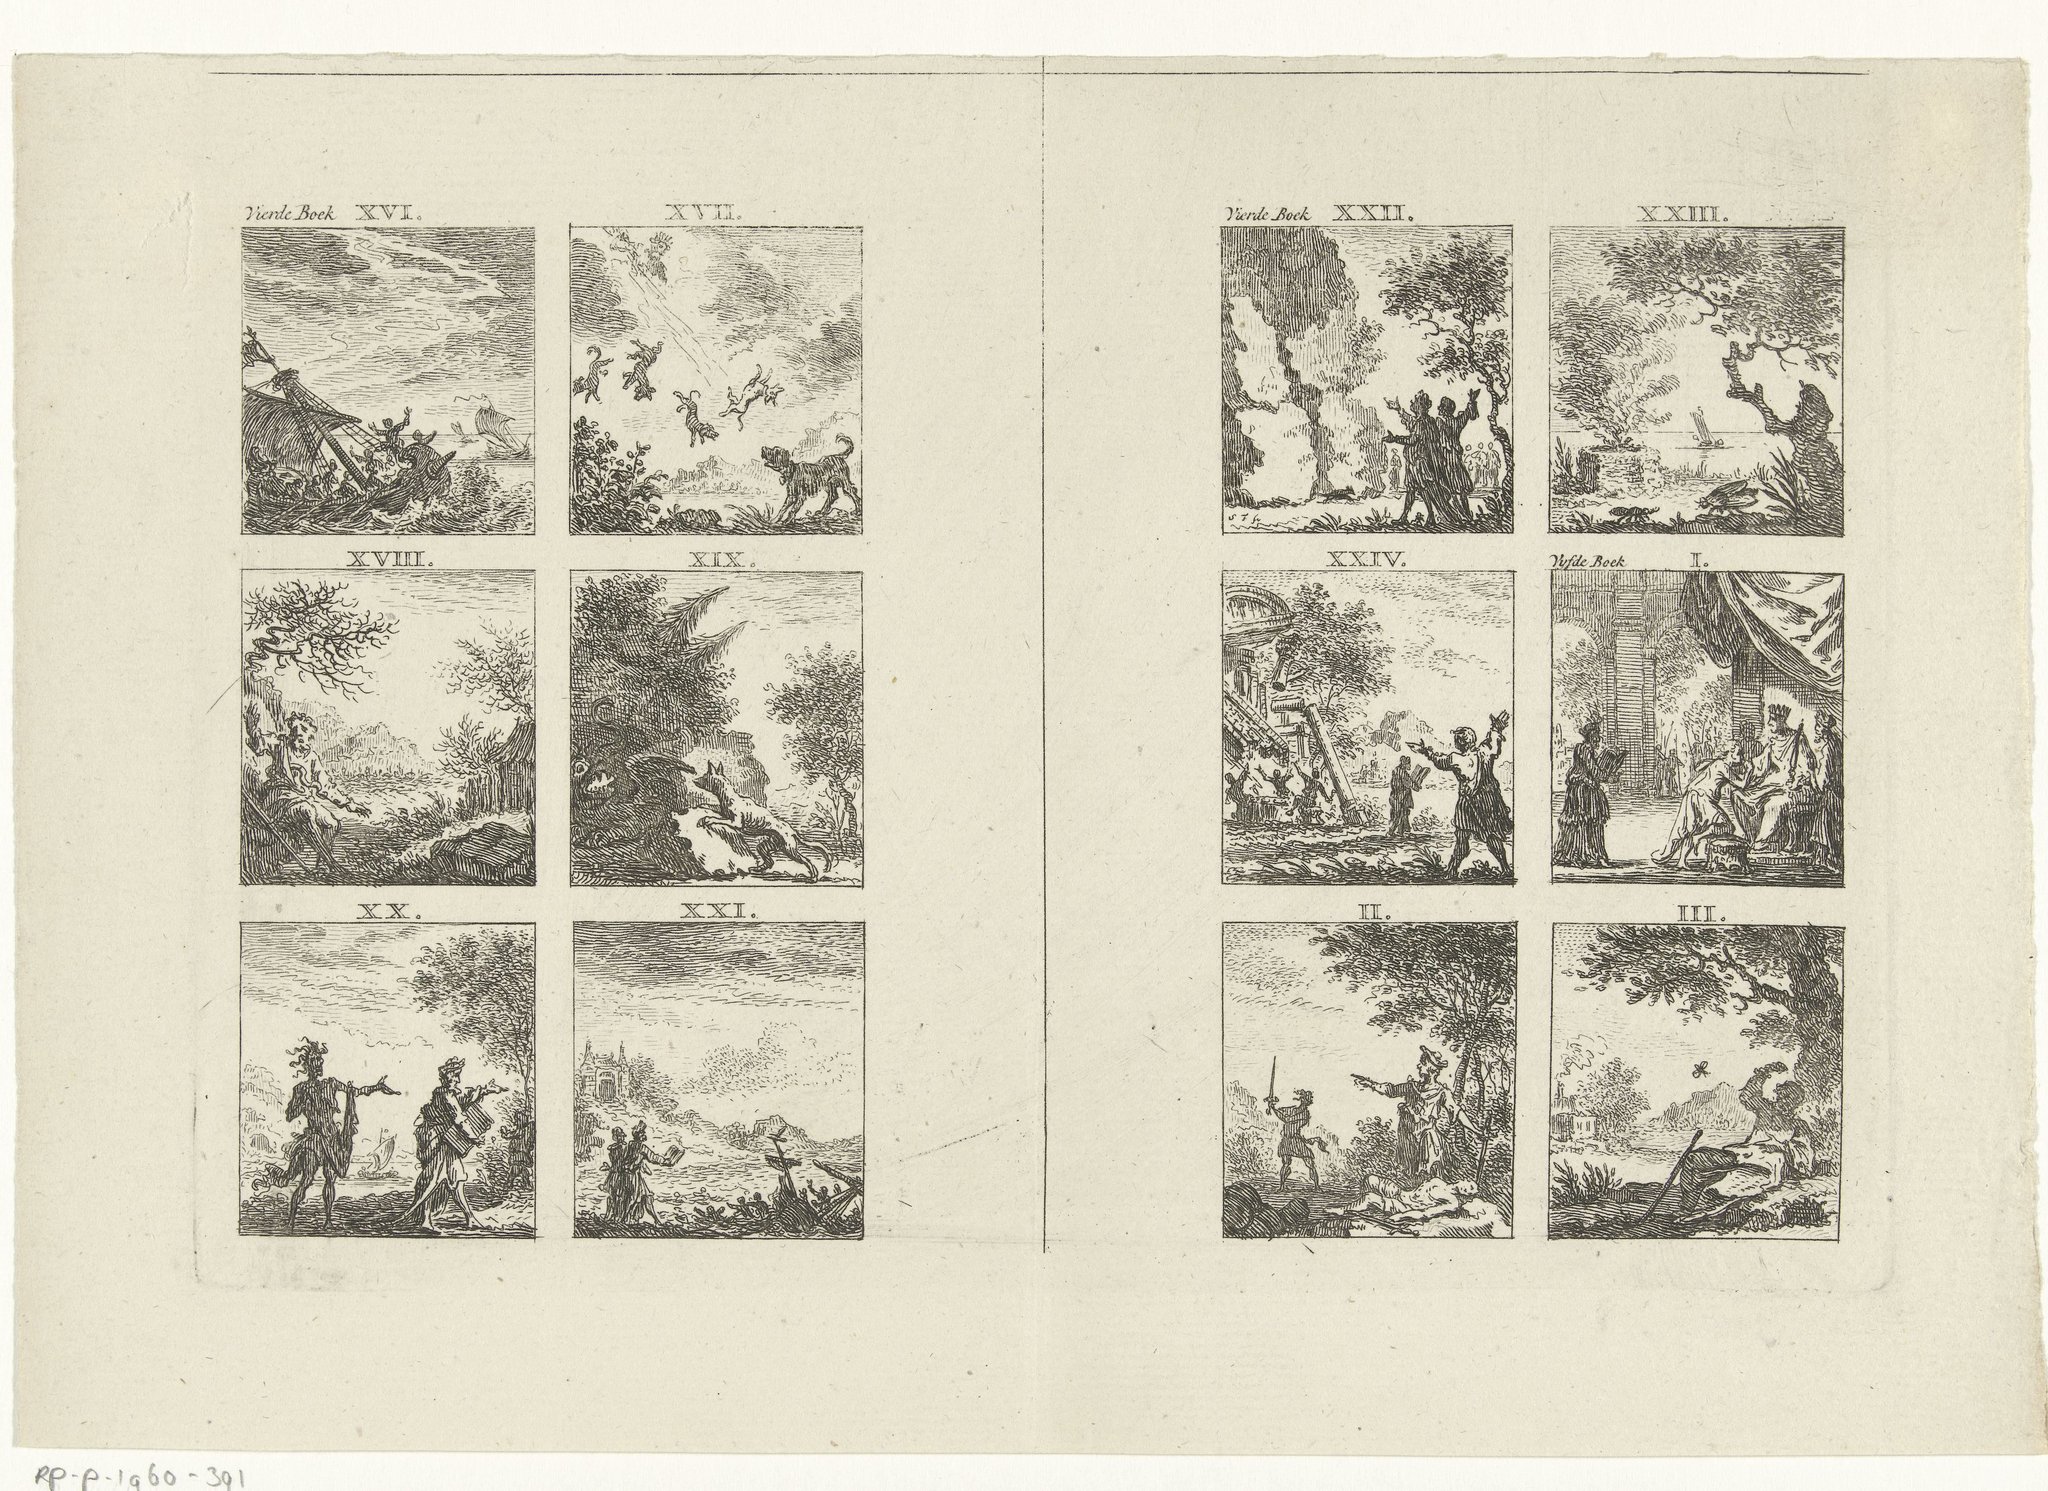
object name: book illustration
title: Twaalf fabel-illustraties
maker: simon fokke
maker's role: draughtsman, print maker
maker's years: 1712-1784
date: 1769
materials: paper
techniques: etching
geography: amsterdam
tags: fables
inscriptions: collector's mark: Lugt 2228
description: Onversneden blad met twaalf fabel-illustraties. Deze fabels behoren tot de Aesopische fabels van de Latijnse dichter Phaedrus. Boven de illustraties die genummerd zijn van XVI tot en met XXIV staat vermeld: Vierde Boek. Boven de illustraties I tot en met III: Vijfde Boek.